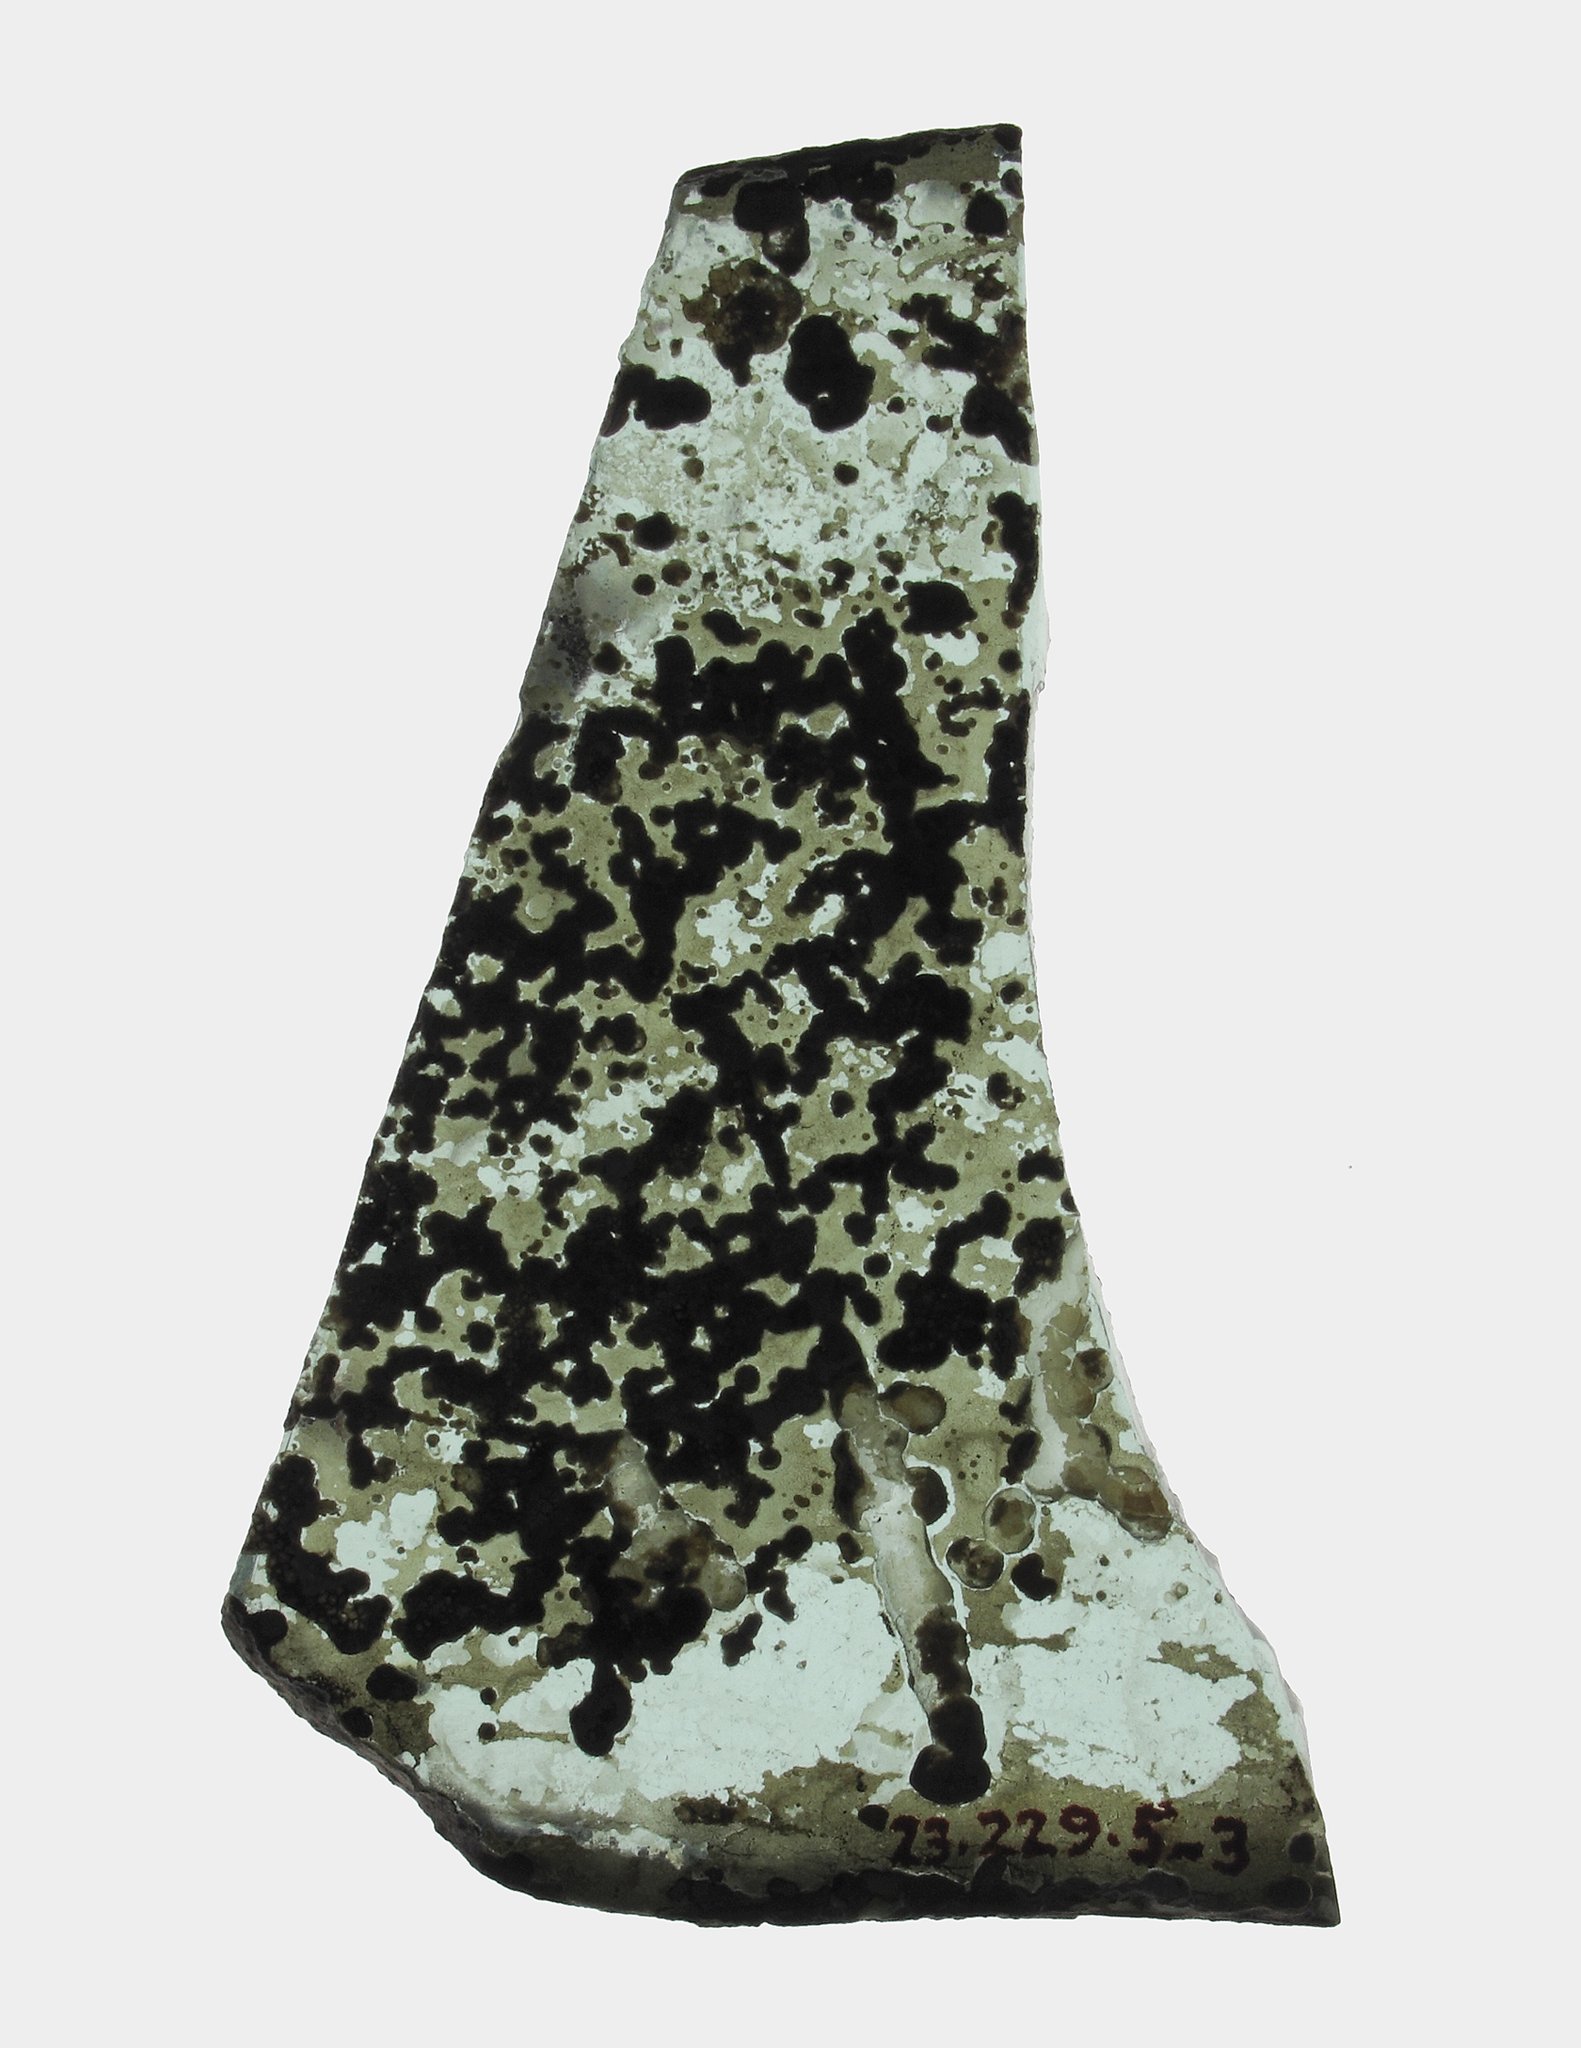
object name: fragment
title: Glass Fragment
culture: french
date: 1101-1200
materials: glass